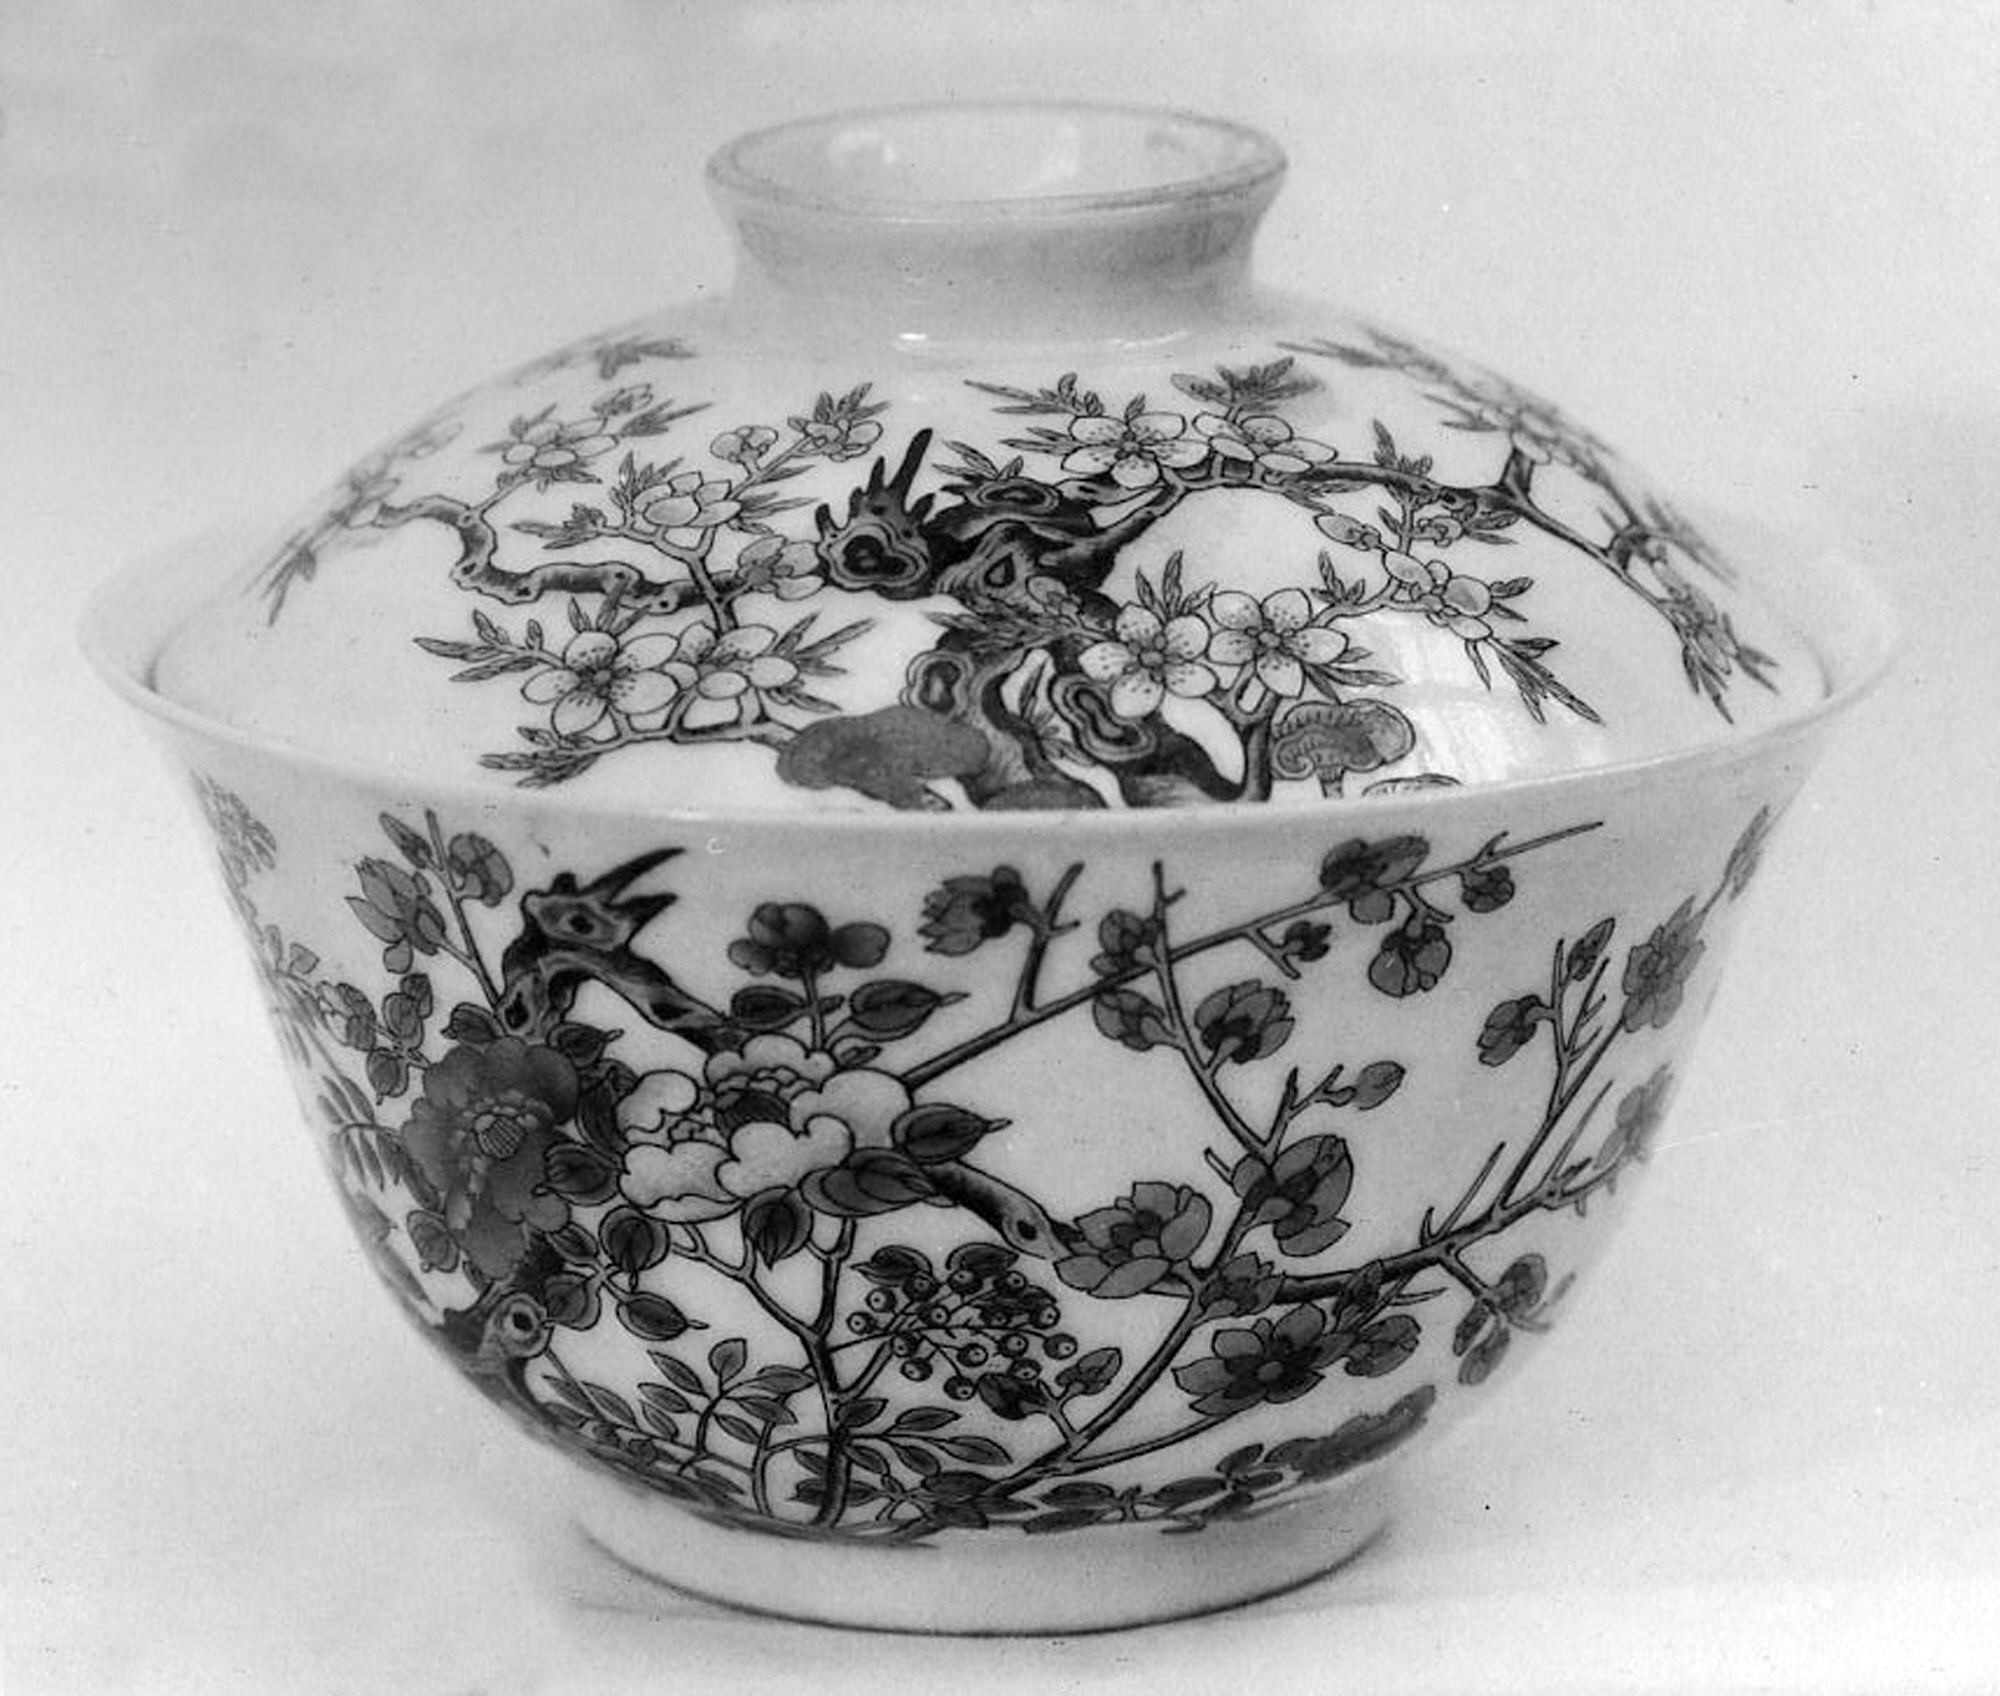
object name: covered cup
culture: chinese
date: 1736-1795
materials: porcelain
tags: flowers